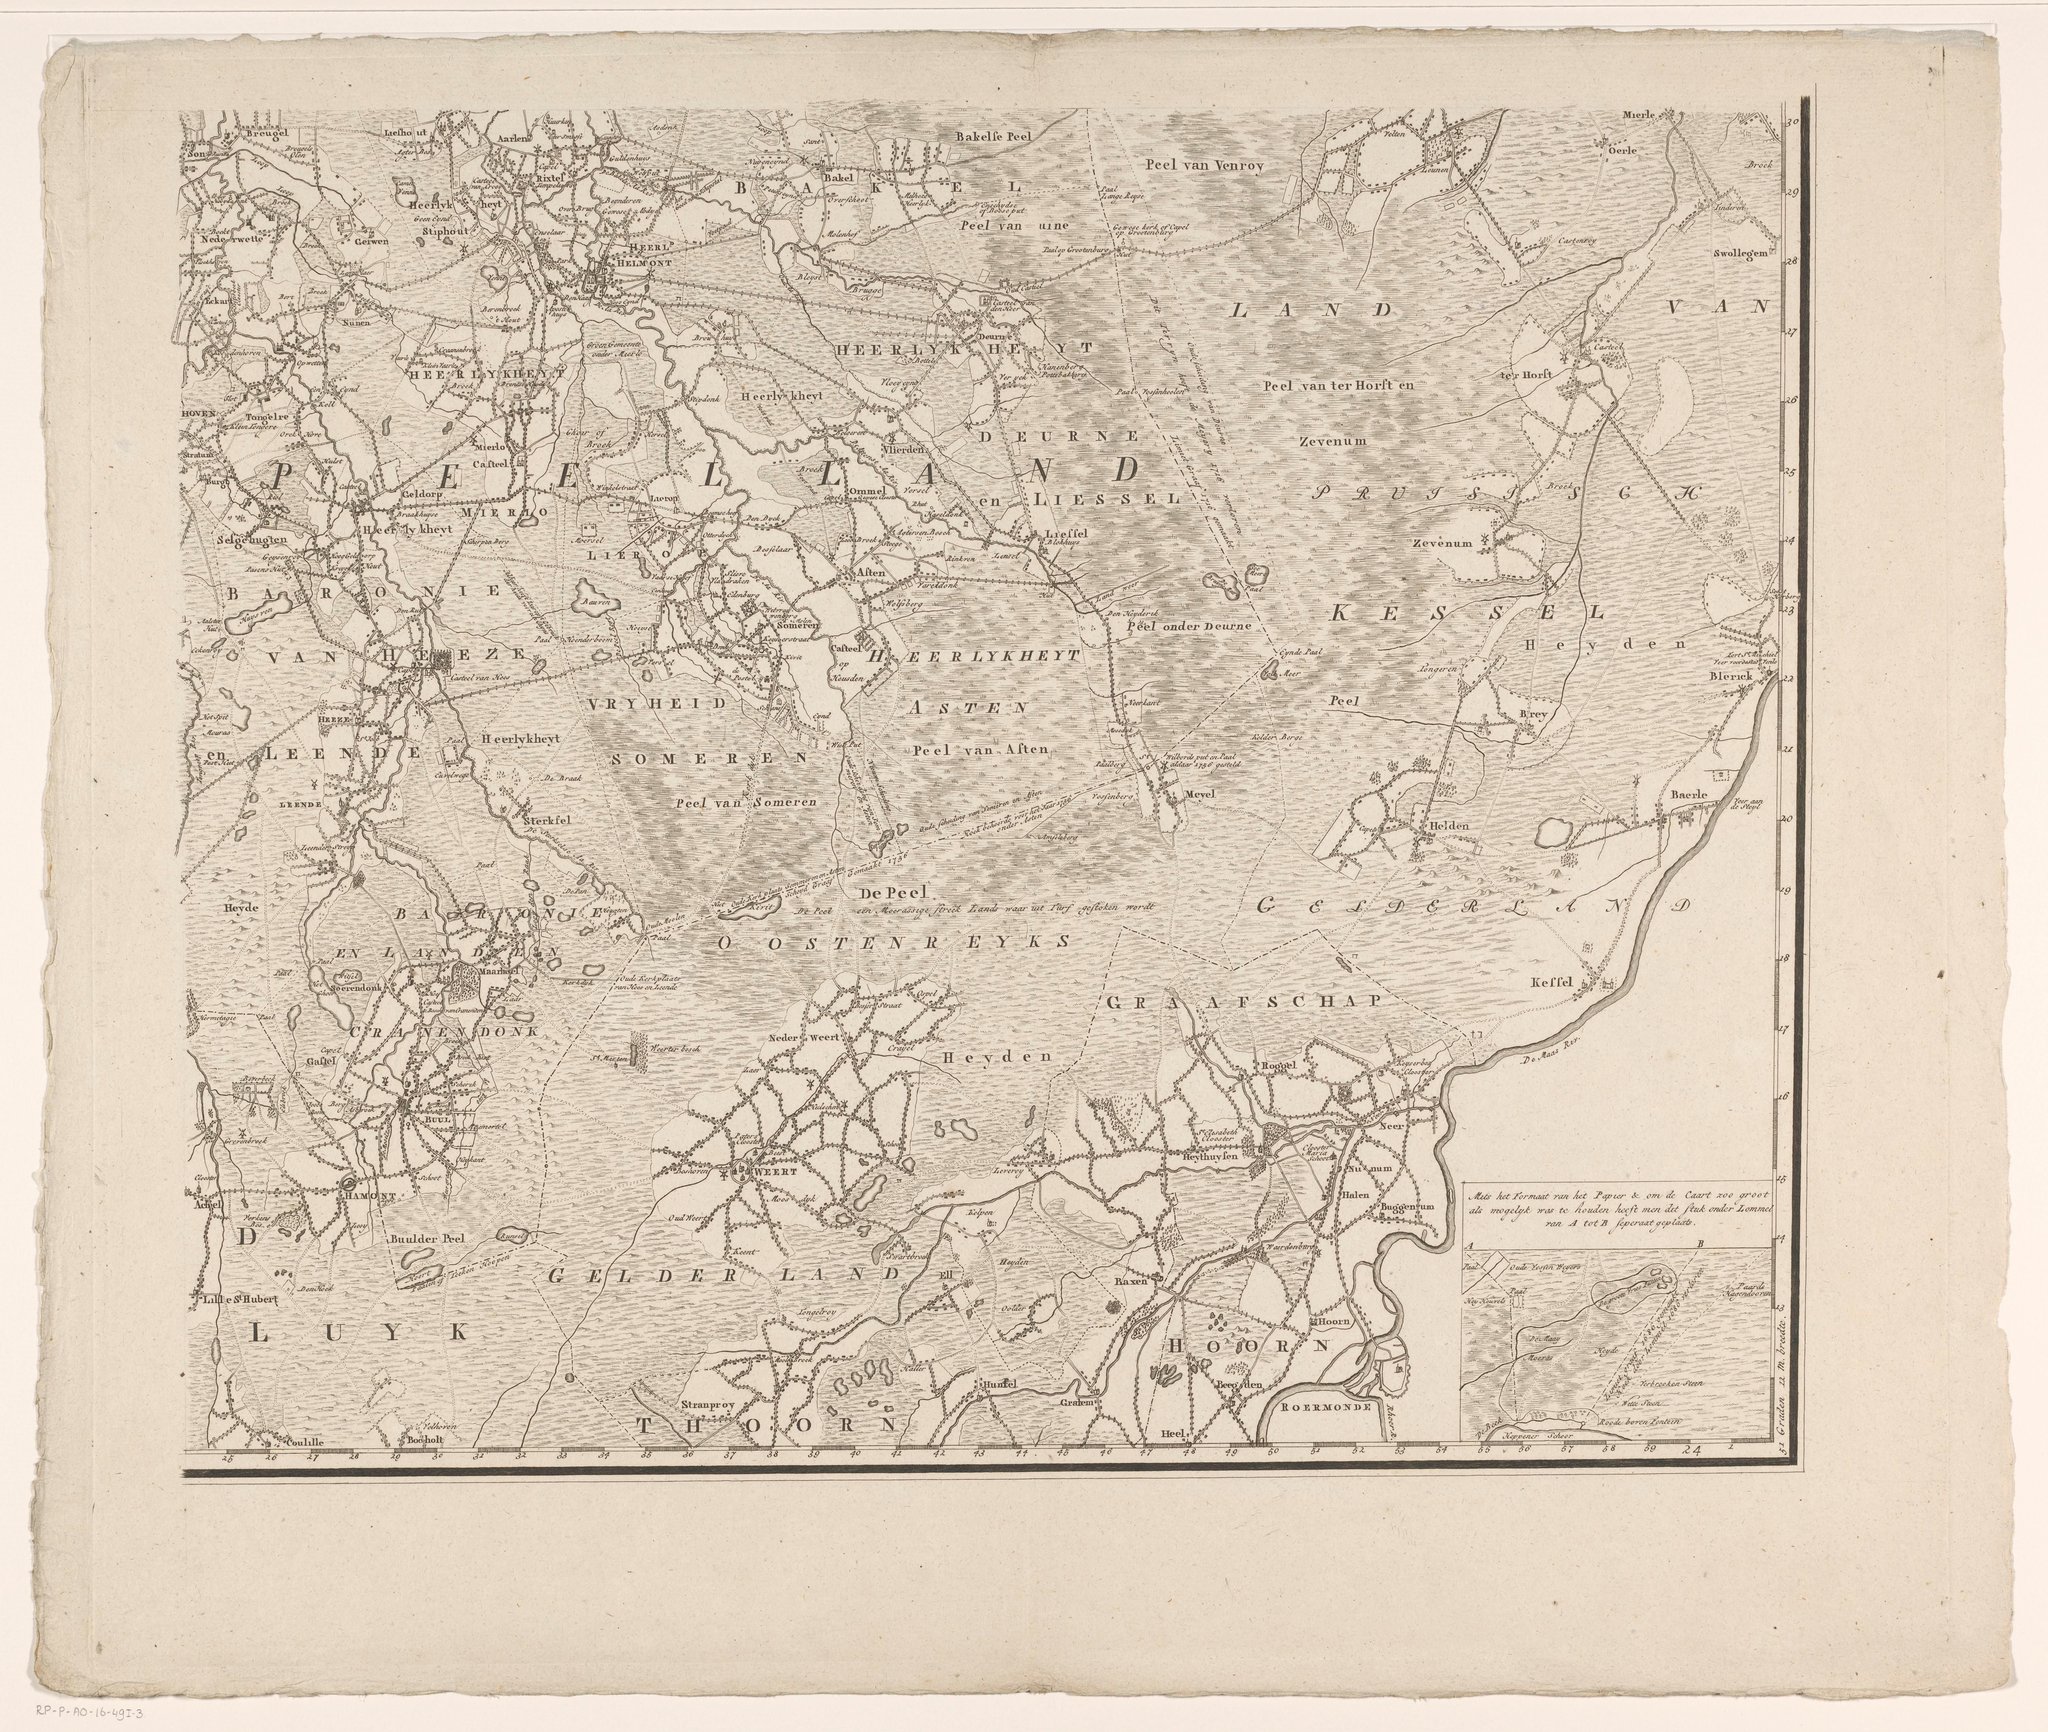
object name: map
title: Kaart figuratief van het grootste gedeelte van Bataasch Braband bevattende de Meyerye van 's Bosch (...)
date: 1794-1797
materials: paper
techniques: engraving, etching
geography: amsterdam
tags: maps of separate countries or regions, brabant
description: Deel (rechtsonder) van een kaart van Brabant, bestaande uit vier delen.